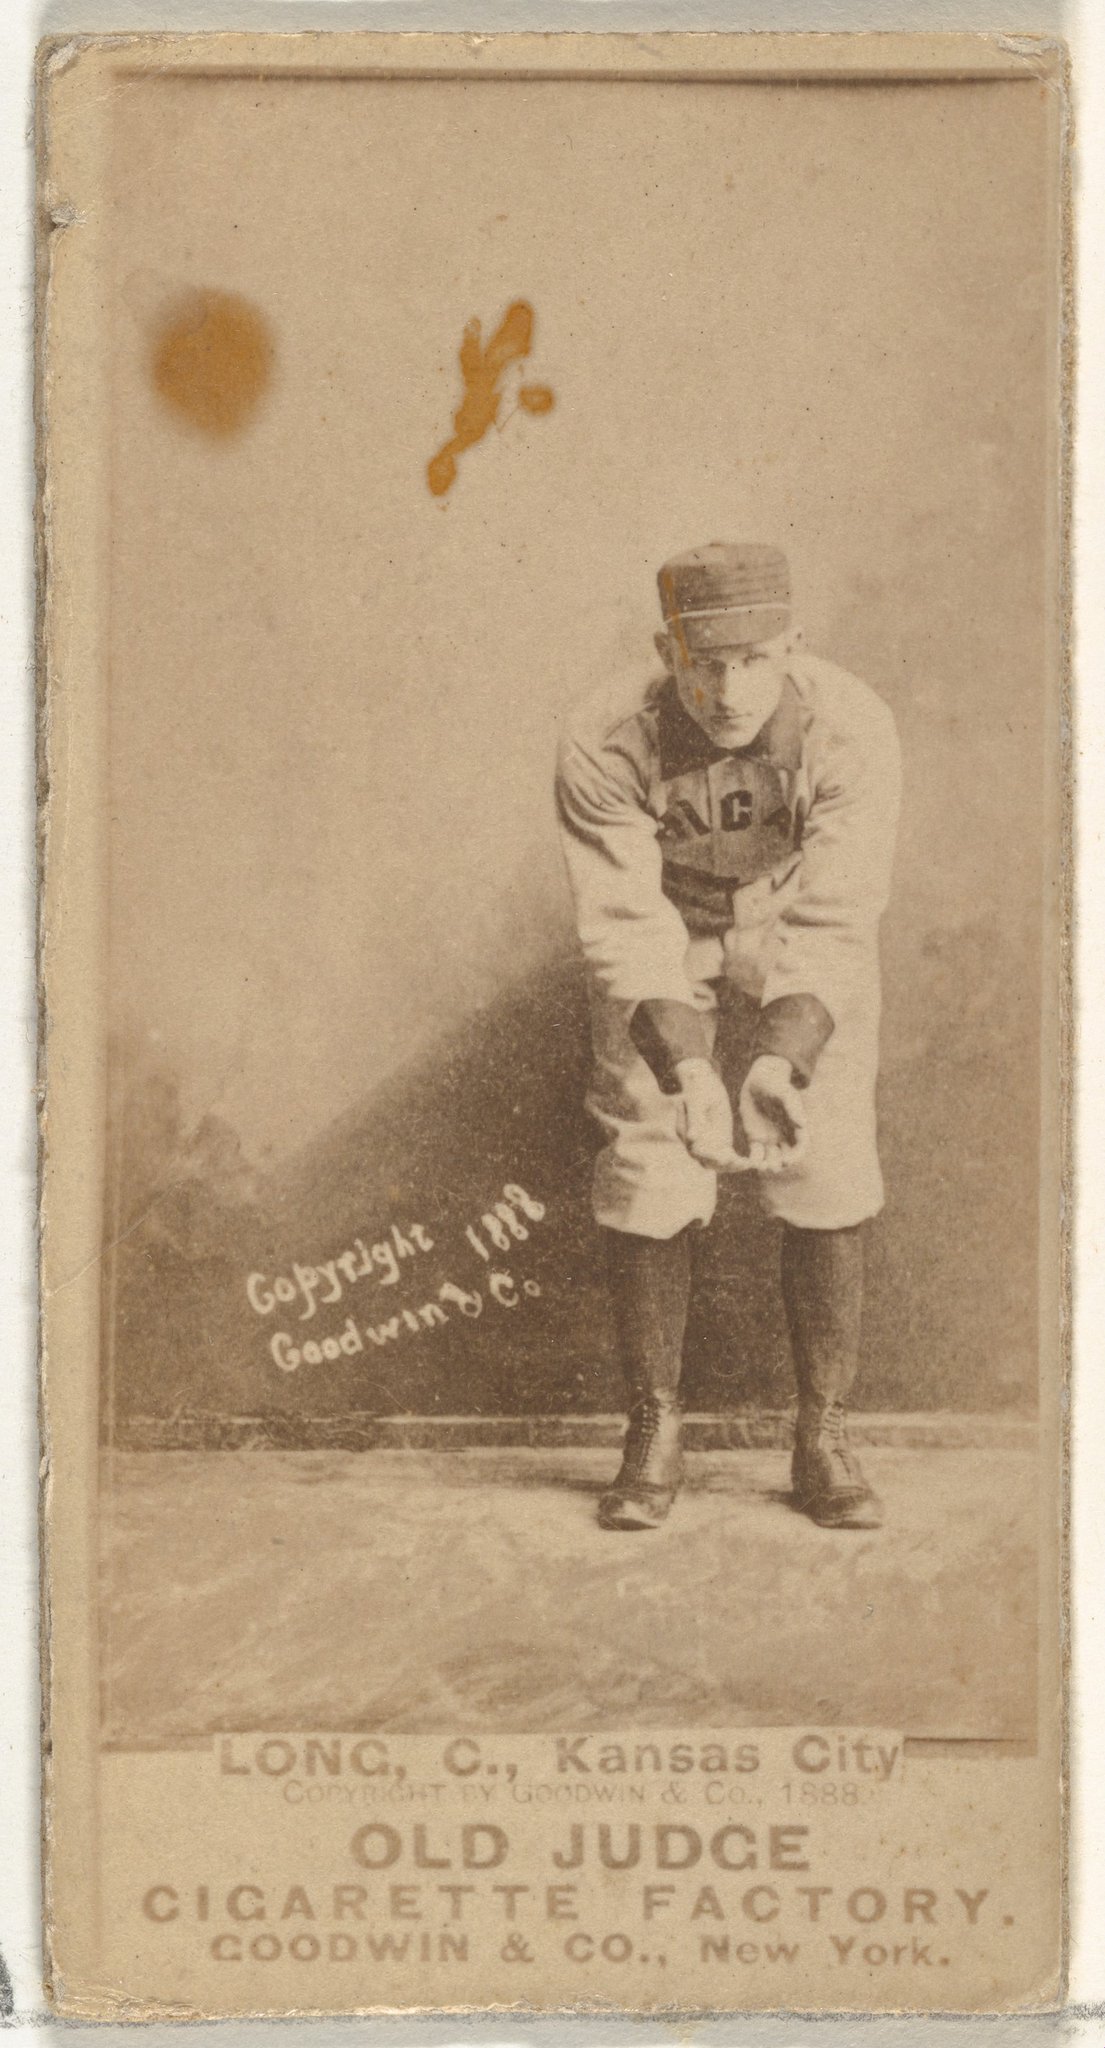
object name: baseball card, photograph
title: Herman C. Long, Catcher, Kansas City Cowboys, from the Old Judge series (N172) for Old Judge Cigarettes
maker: goodwin & company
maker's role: publisher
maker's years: 1850-1950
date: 1888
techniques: albumen silver print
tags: men,portraits,baseball,athletes